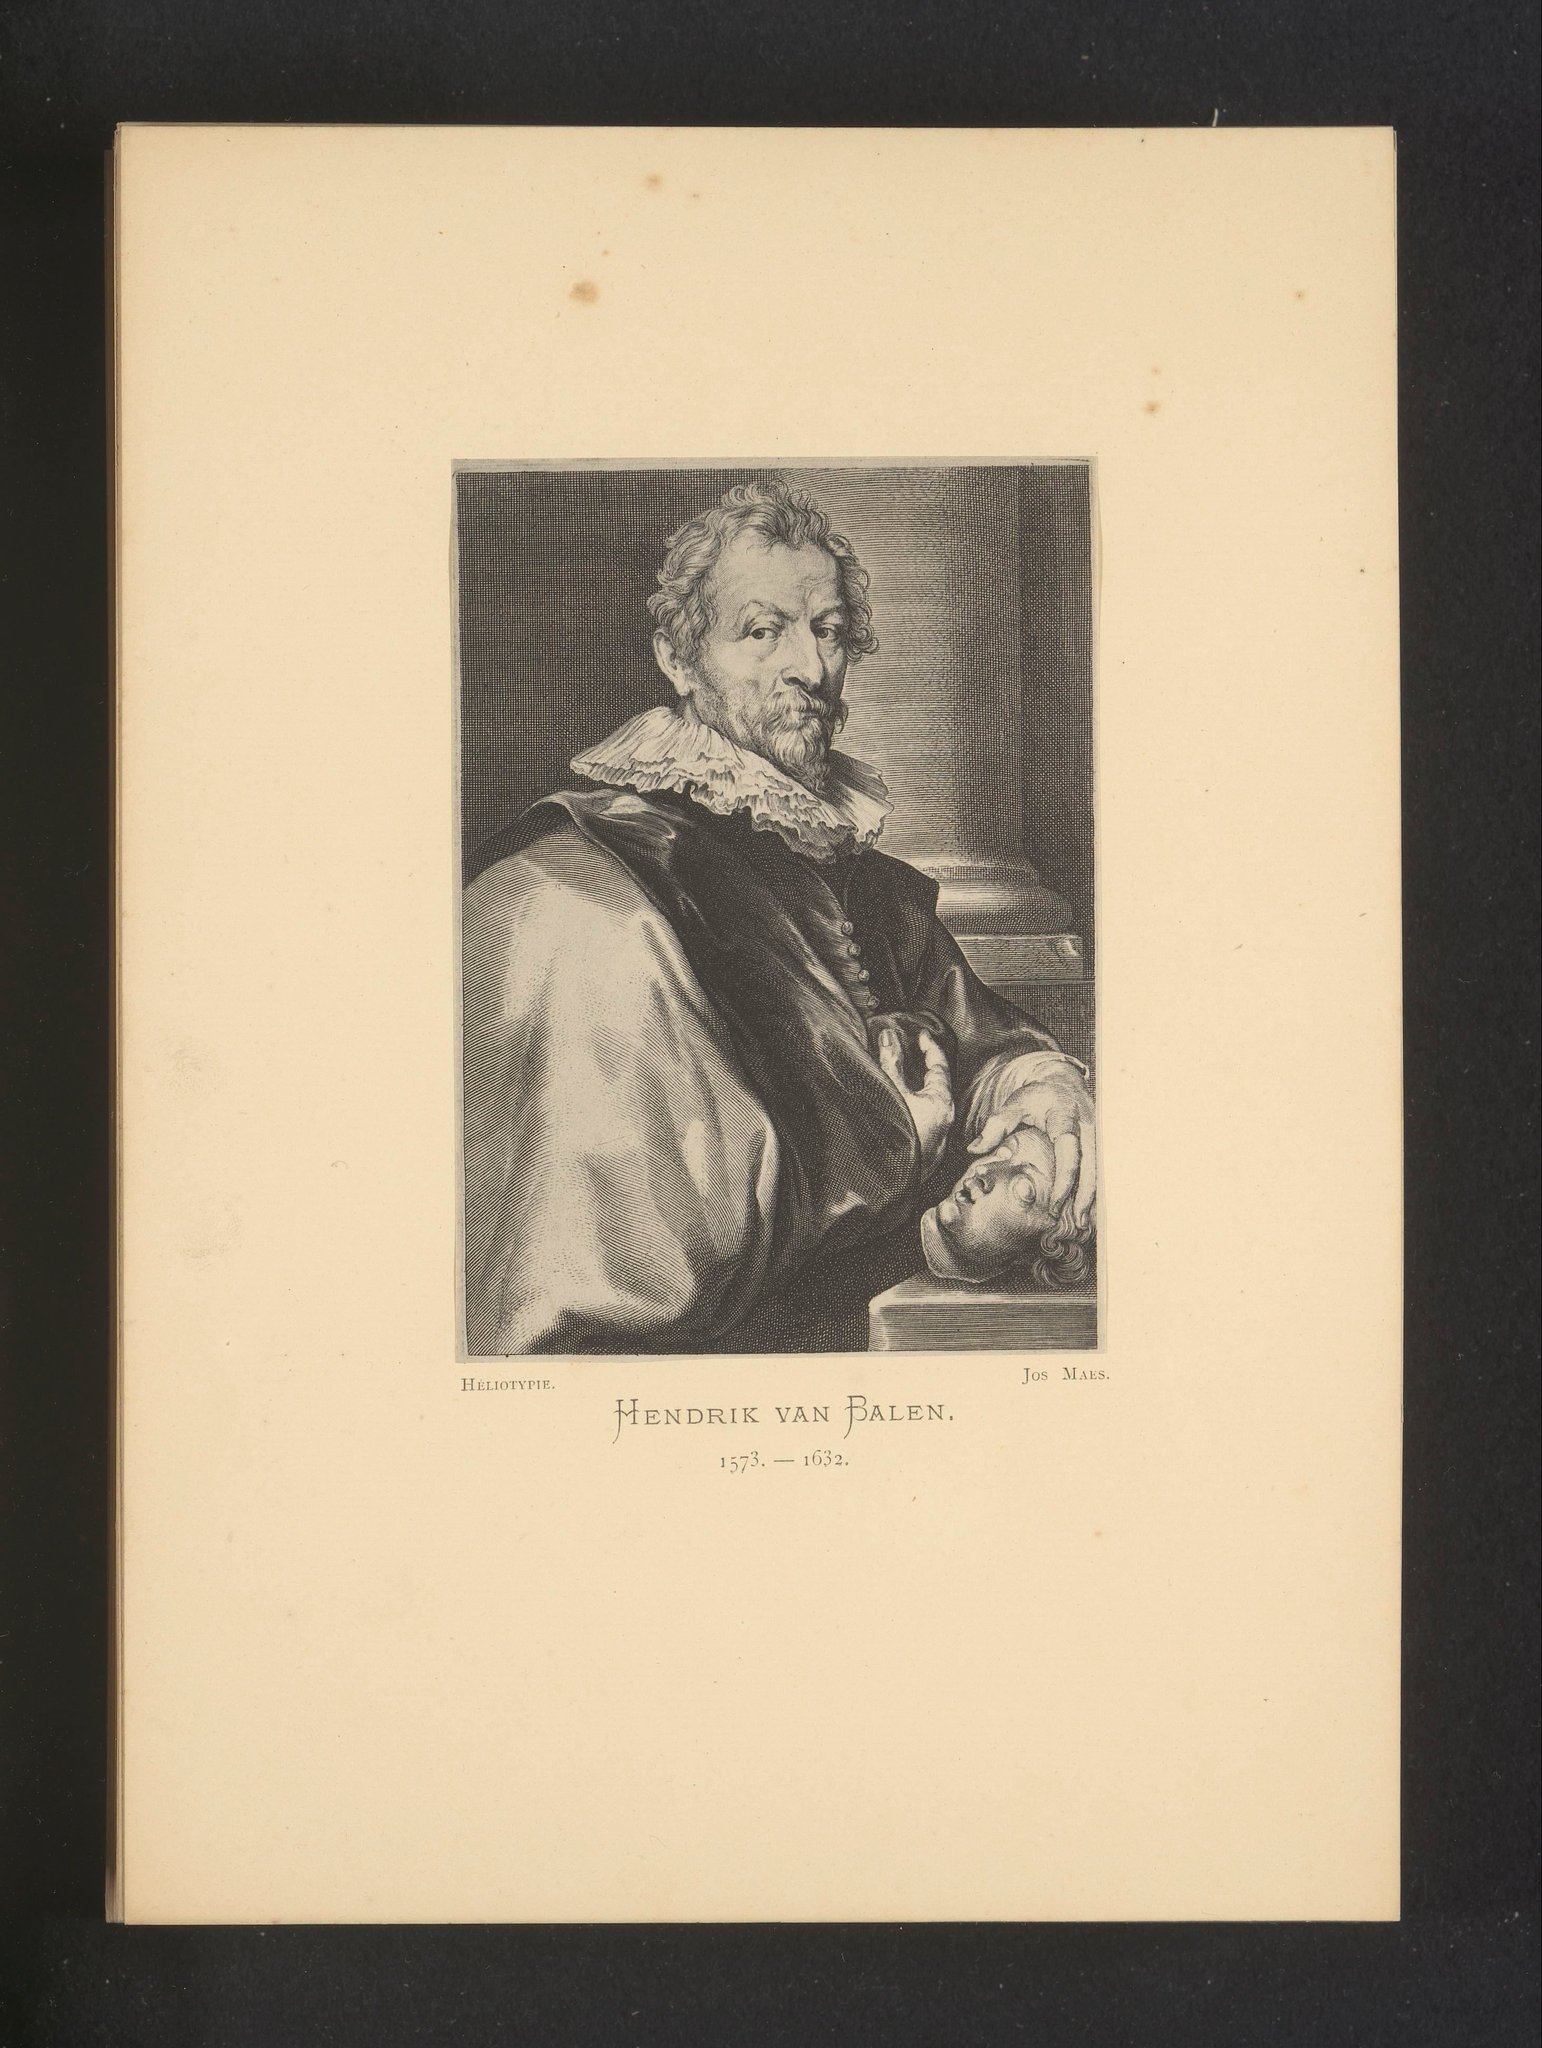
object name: reproduction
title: Hendrik van Balen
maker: joseph maes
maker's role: fotograaf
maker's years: 1838-1908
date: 1872-1877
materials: cardboard, paper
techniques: photograph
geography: antwerp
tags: antwerp, painter, draughtsman, hendrik van balen (i), historical persons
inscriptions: inscription: ‘1573. - 1632.’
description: Deze prent maakt deel uit van een omslag met 150 prenten en een katern met een lijst van afbeeldingen.